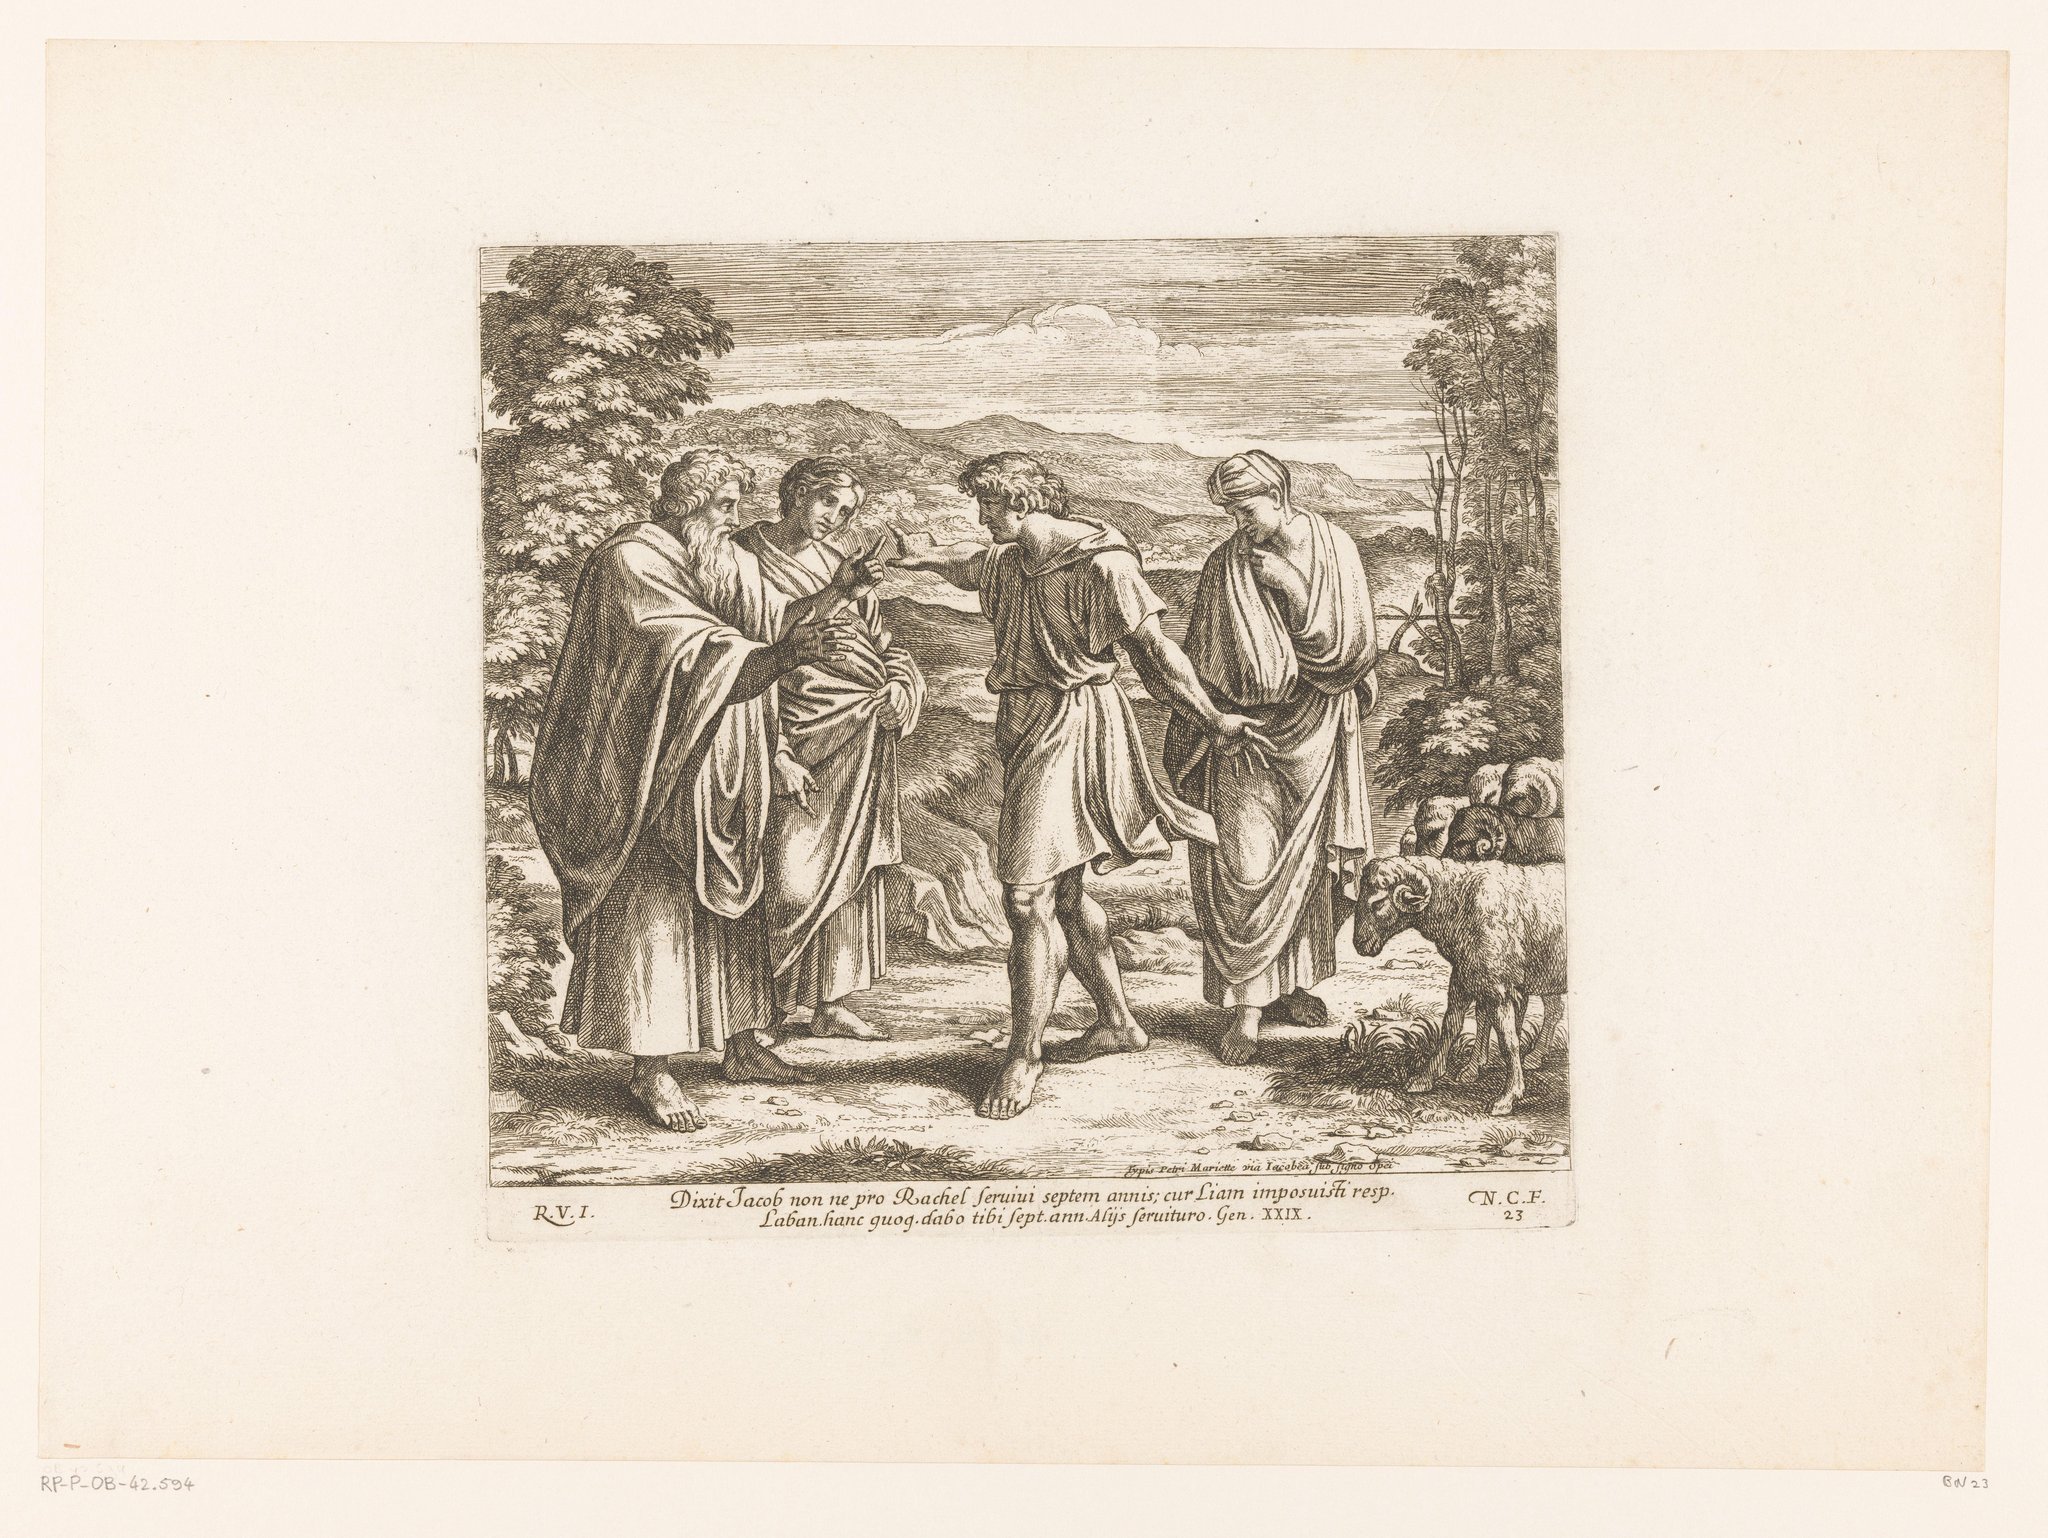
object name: print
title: Sacrae Historiae Acta a Raphael Urbin in Vaticanis xystis ad picturae miraculum expressa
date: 1649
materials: paper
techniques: etching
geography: vatican city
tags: after the wedding-night jacob discovers that he has been deceived with leah and complains to laban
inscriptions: collector's mark: Lugt 2228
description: Prent uit de Sacrae Historiae Acta a Raphael Urbin in Vaticanis xystis ad picturae miraculum expressa, ook bekend als de Rafaël Bijbel. De serie bestaat uit 54 platen, waarvan twee titelprenten, de eerste met een opdracht aan Rafaël, de tweede met een opdracht aan Renard. De overige 52 platen betreffen composities naar schilderingen in de Loggia van Rafaël in het Vaticaan. De serie werd in 1649 uitgegeven door Pierre Mariette te Parijs.